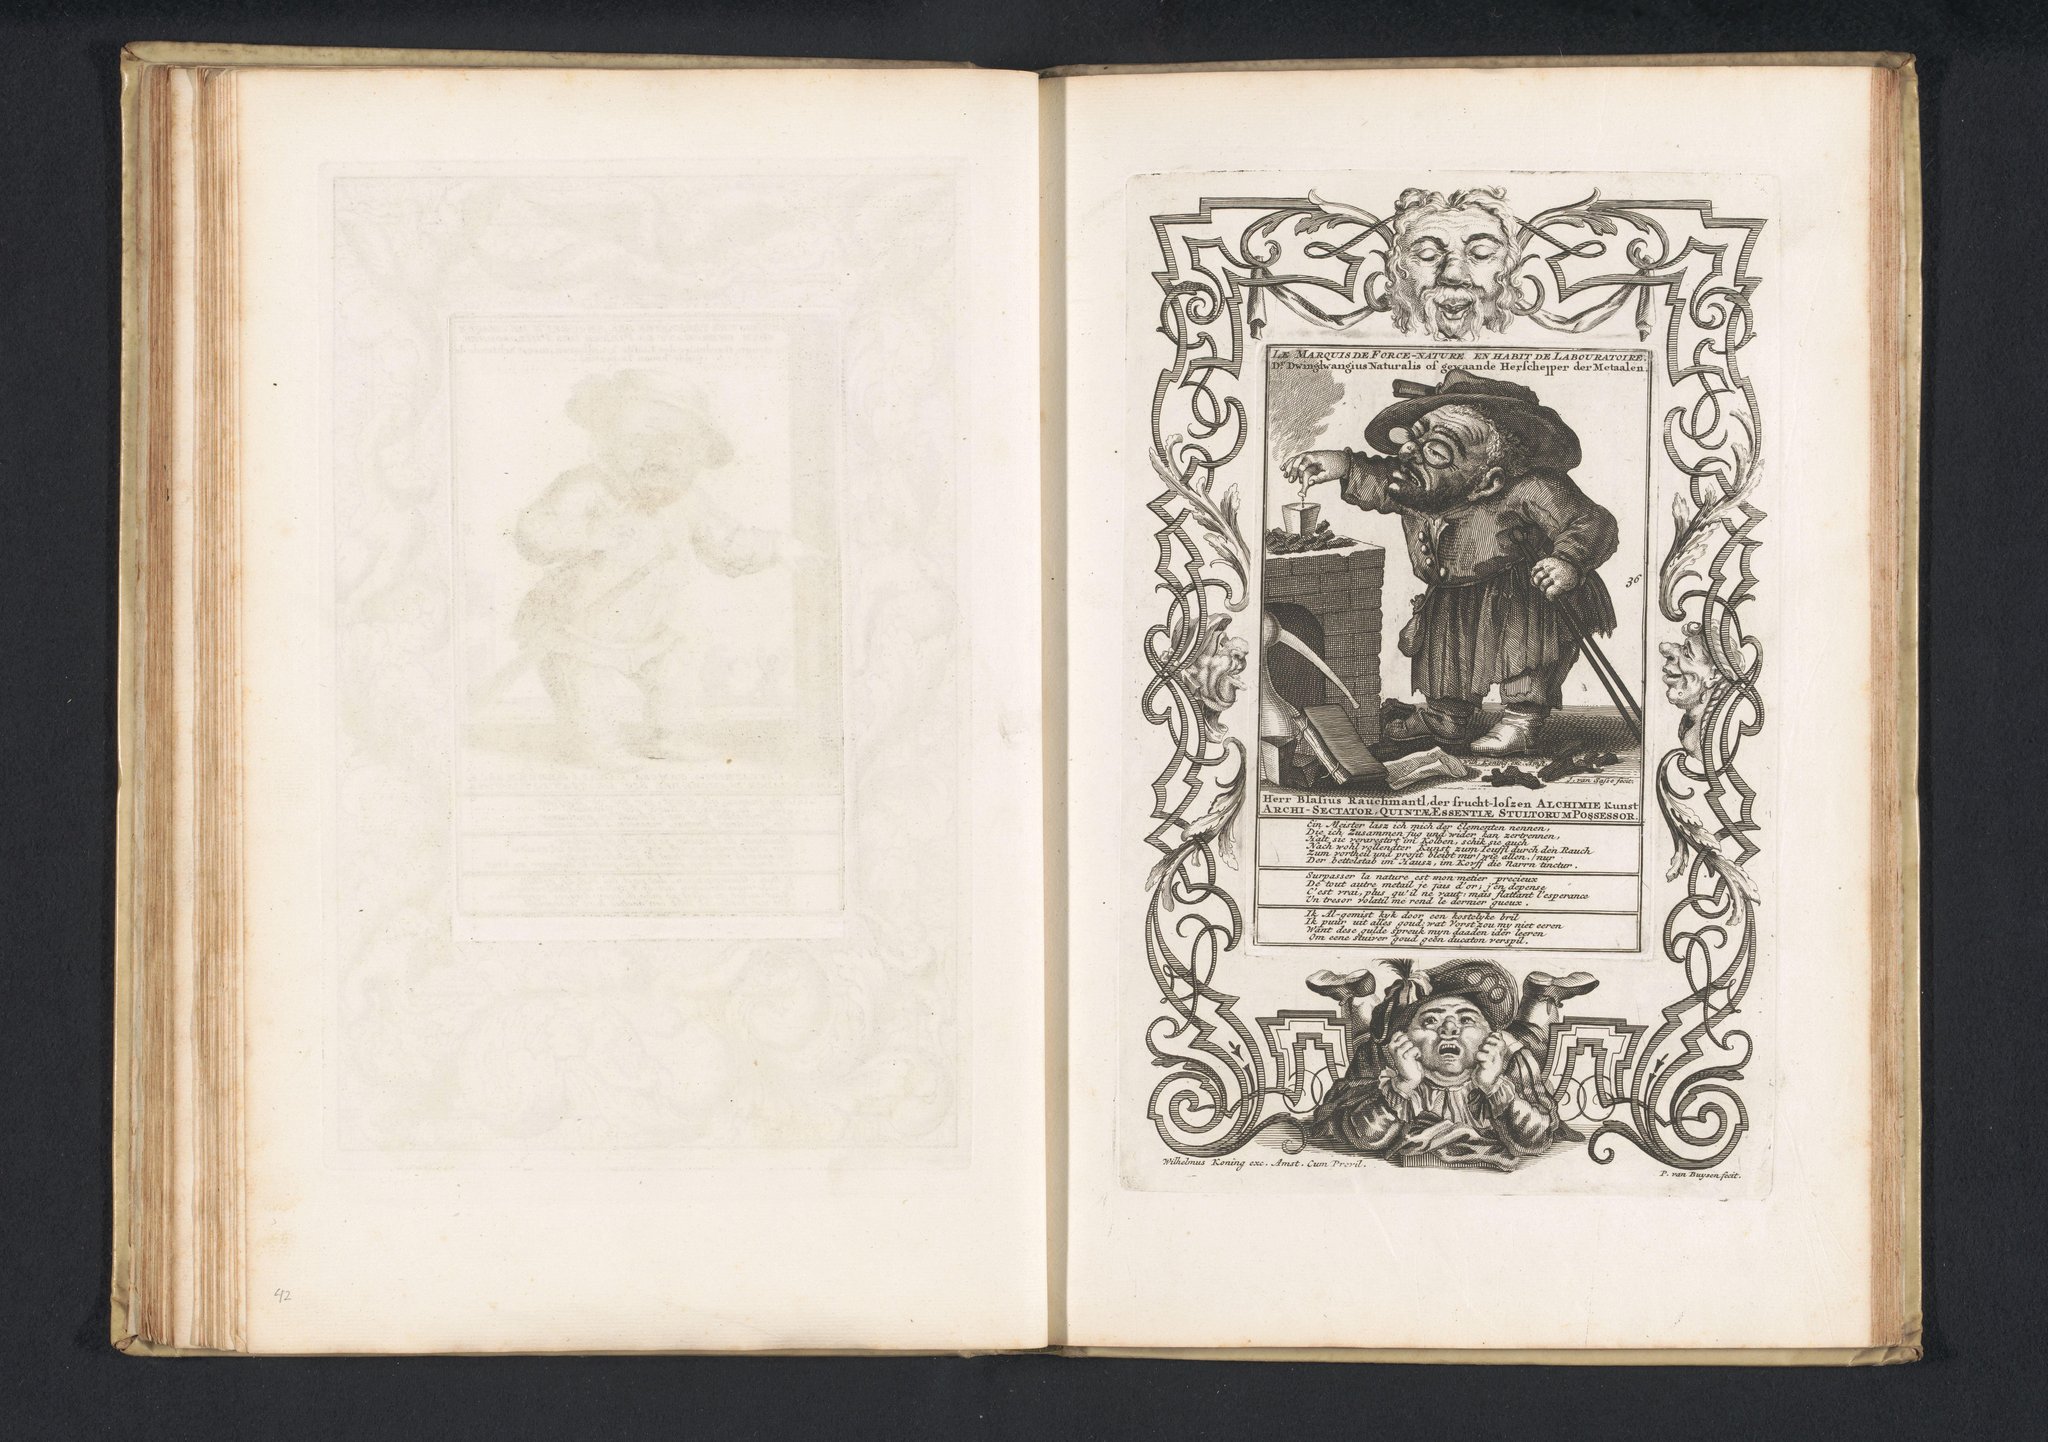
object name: print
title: De dwerg Dr. Dwingdwangius Naturalis als alchemist, 1720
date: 1716-1720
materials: paper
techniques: etching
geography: northern netherlands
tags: caricatures (human types), little people, alchemist at work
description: De kleine mens Dr. Dwingdwangius Naturalis als alchemist. In het onderschrift verzen in het Duits, Frans en Nederlands. Genummerd rechts midden: 36. Afdruk binnen een decoratieve omlijsting gedrukt van een aparte plaat met kleine mensen. Onderdeel van deel II in de tweede Nederlandse gebonden uitgave uit 1720 (en gerelateerd aan de Windhandel in dat jaar) van een serie karikaturen van kleine mensen, bekend als Het Dwergentooneel, deels gekopieerd naar een ouder Duits voorbeeld.